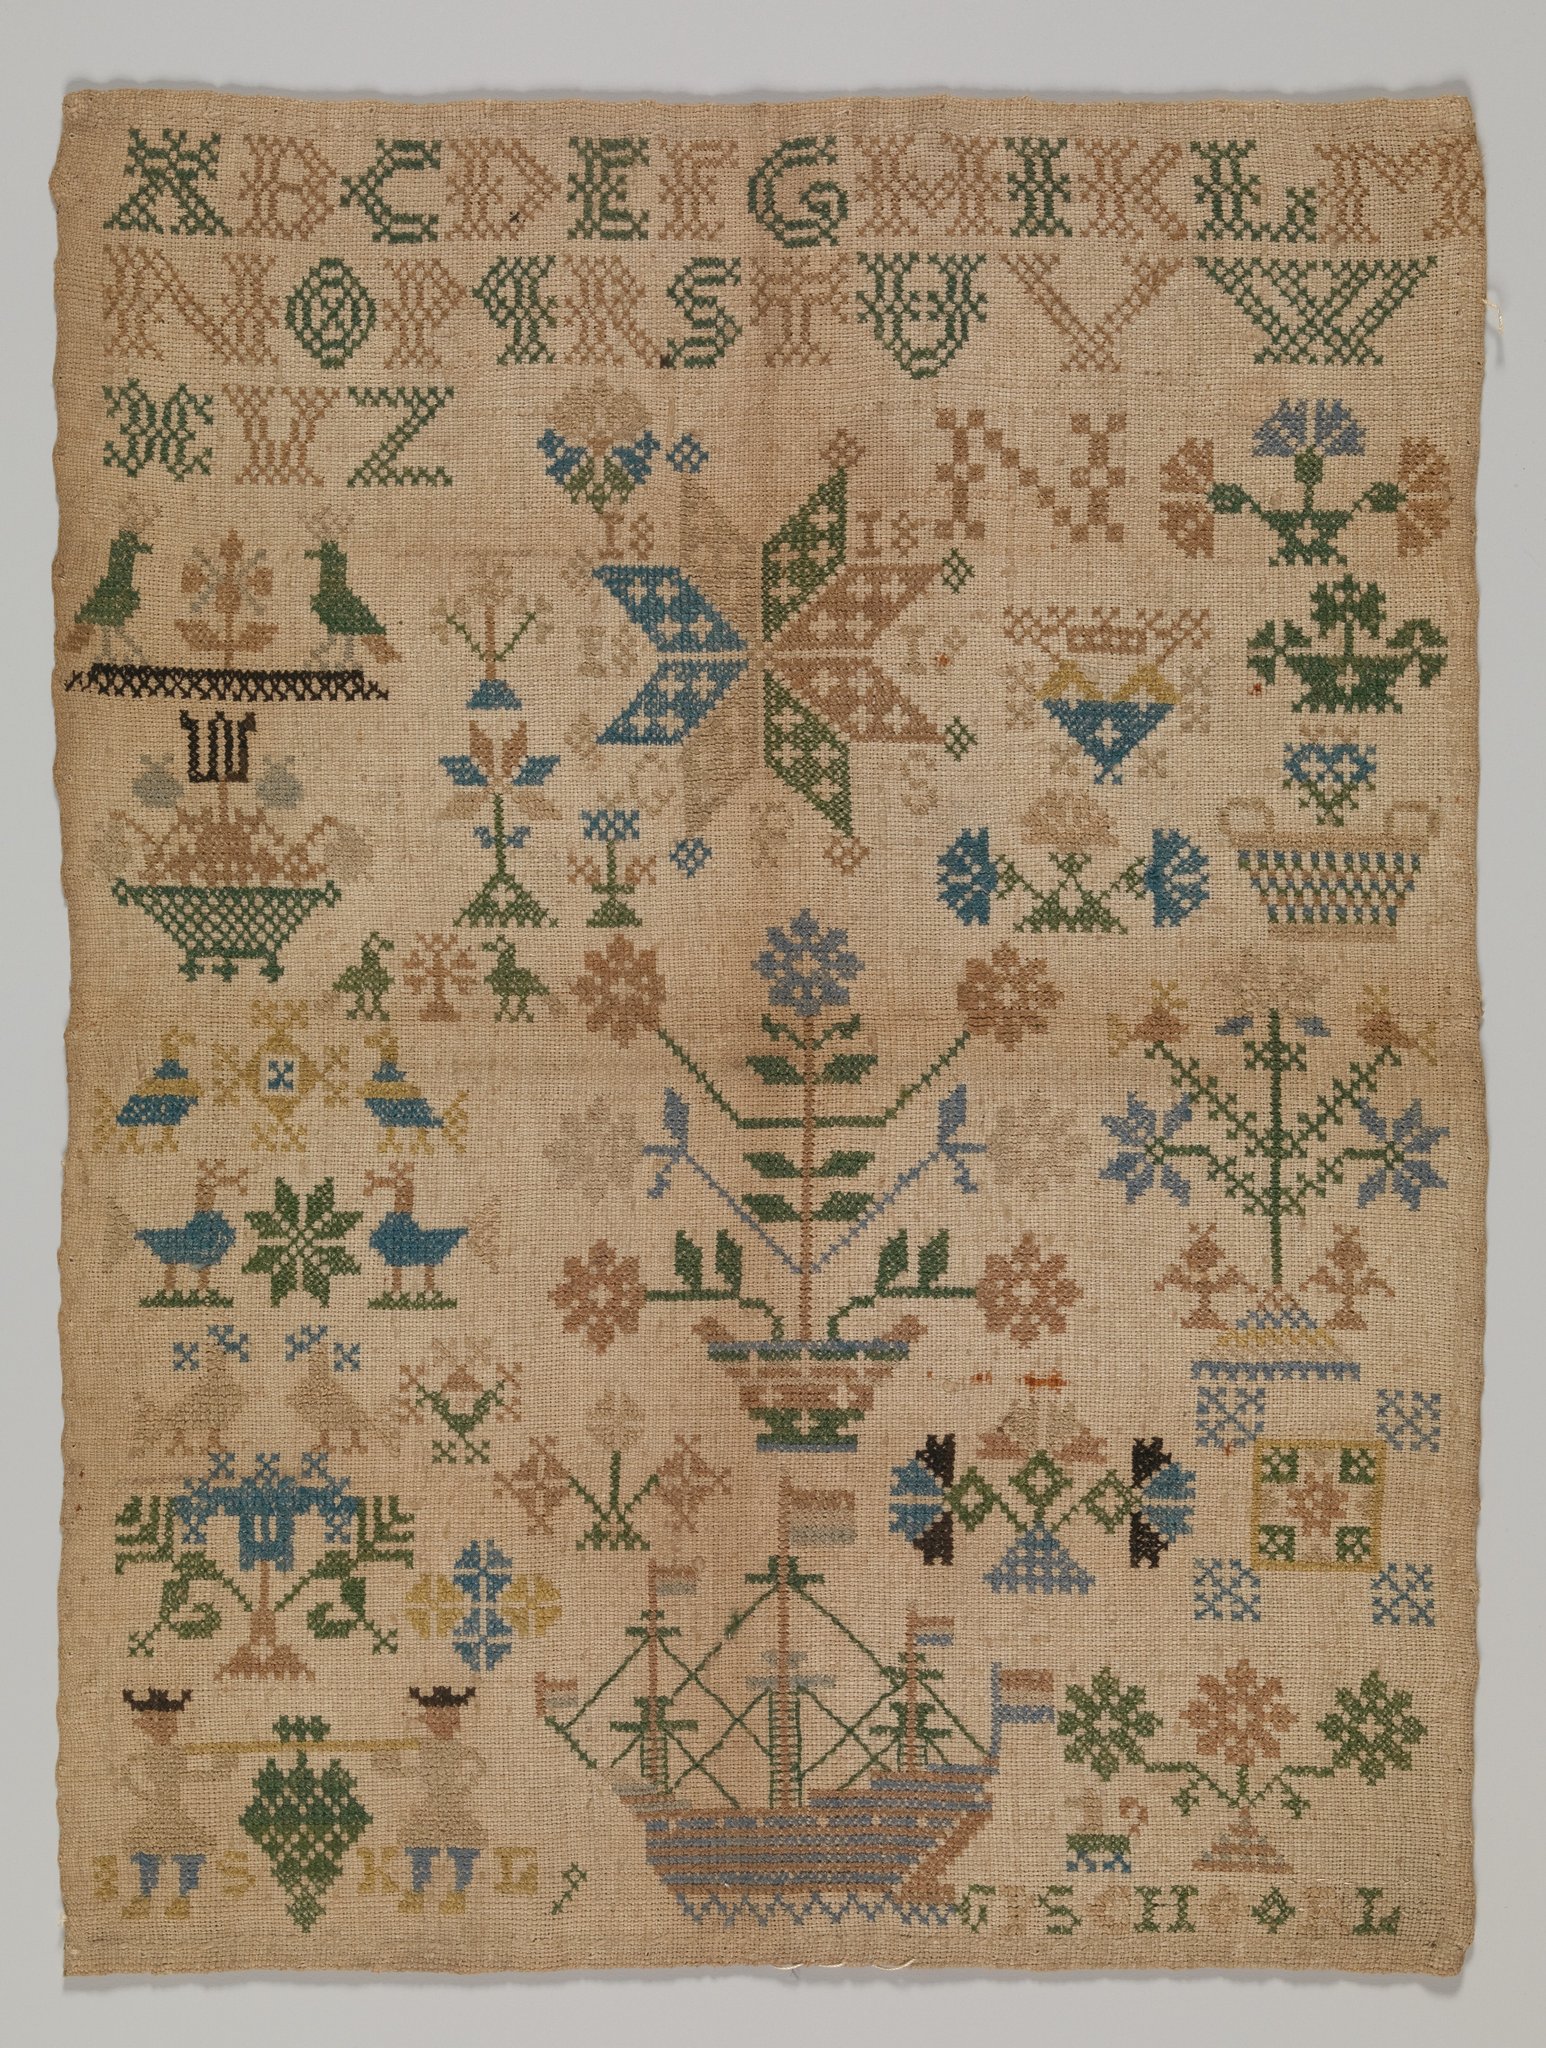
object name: sampler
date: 1818-1819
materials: linen, silk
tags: birds,flowers,ships